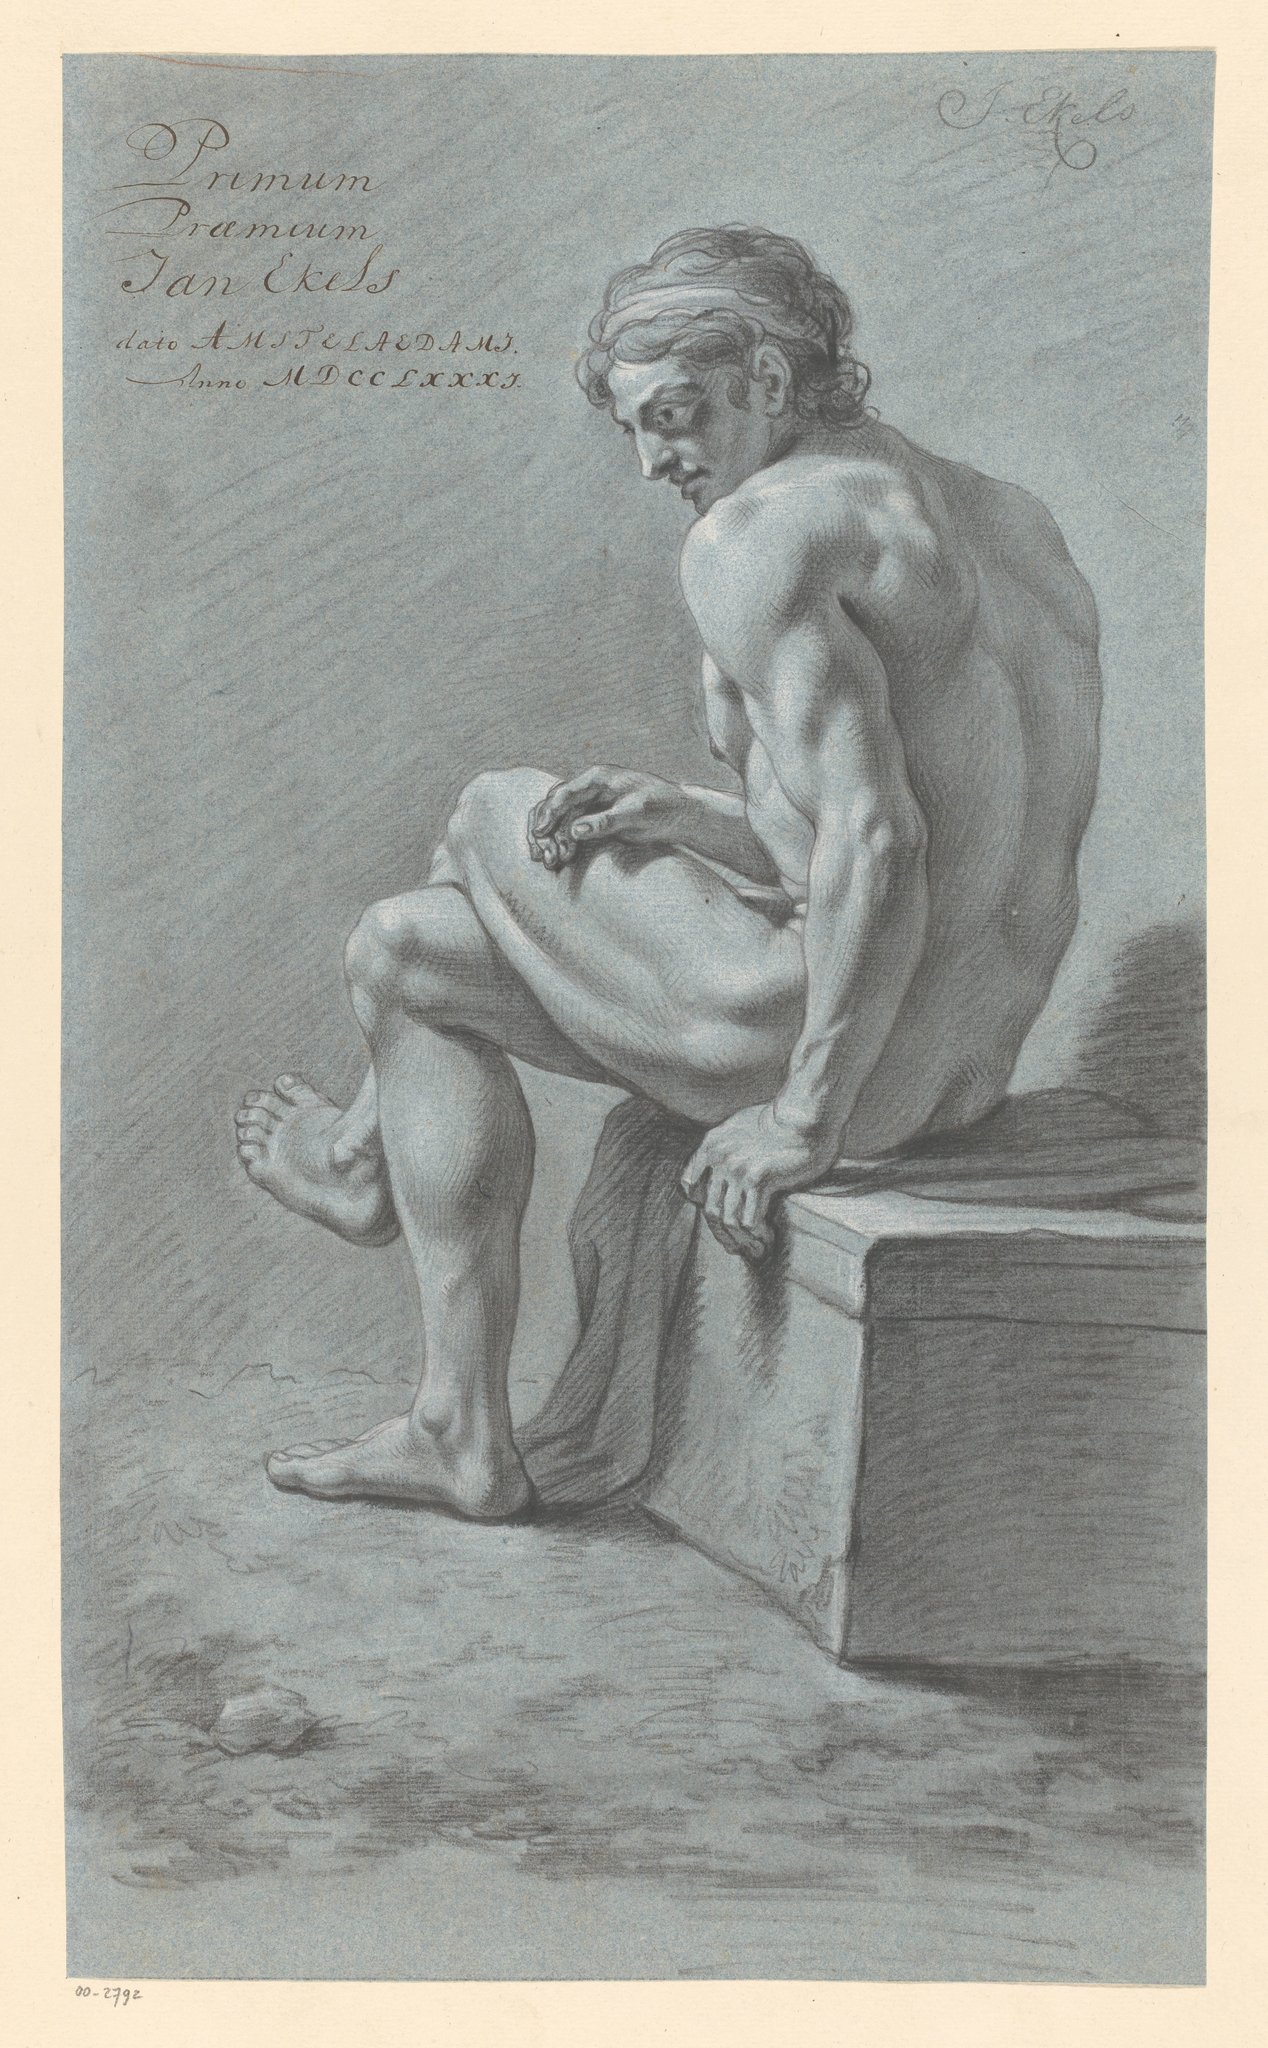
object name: drawing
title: Zittend mannelijk naakt, op de rug gezien (1e prijs 1781)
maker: jan ekels (ii)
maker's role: draughtsman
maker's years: 1759-1793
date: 1781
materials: chalk, paper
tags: sitting figure (+ nude human being)